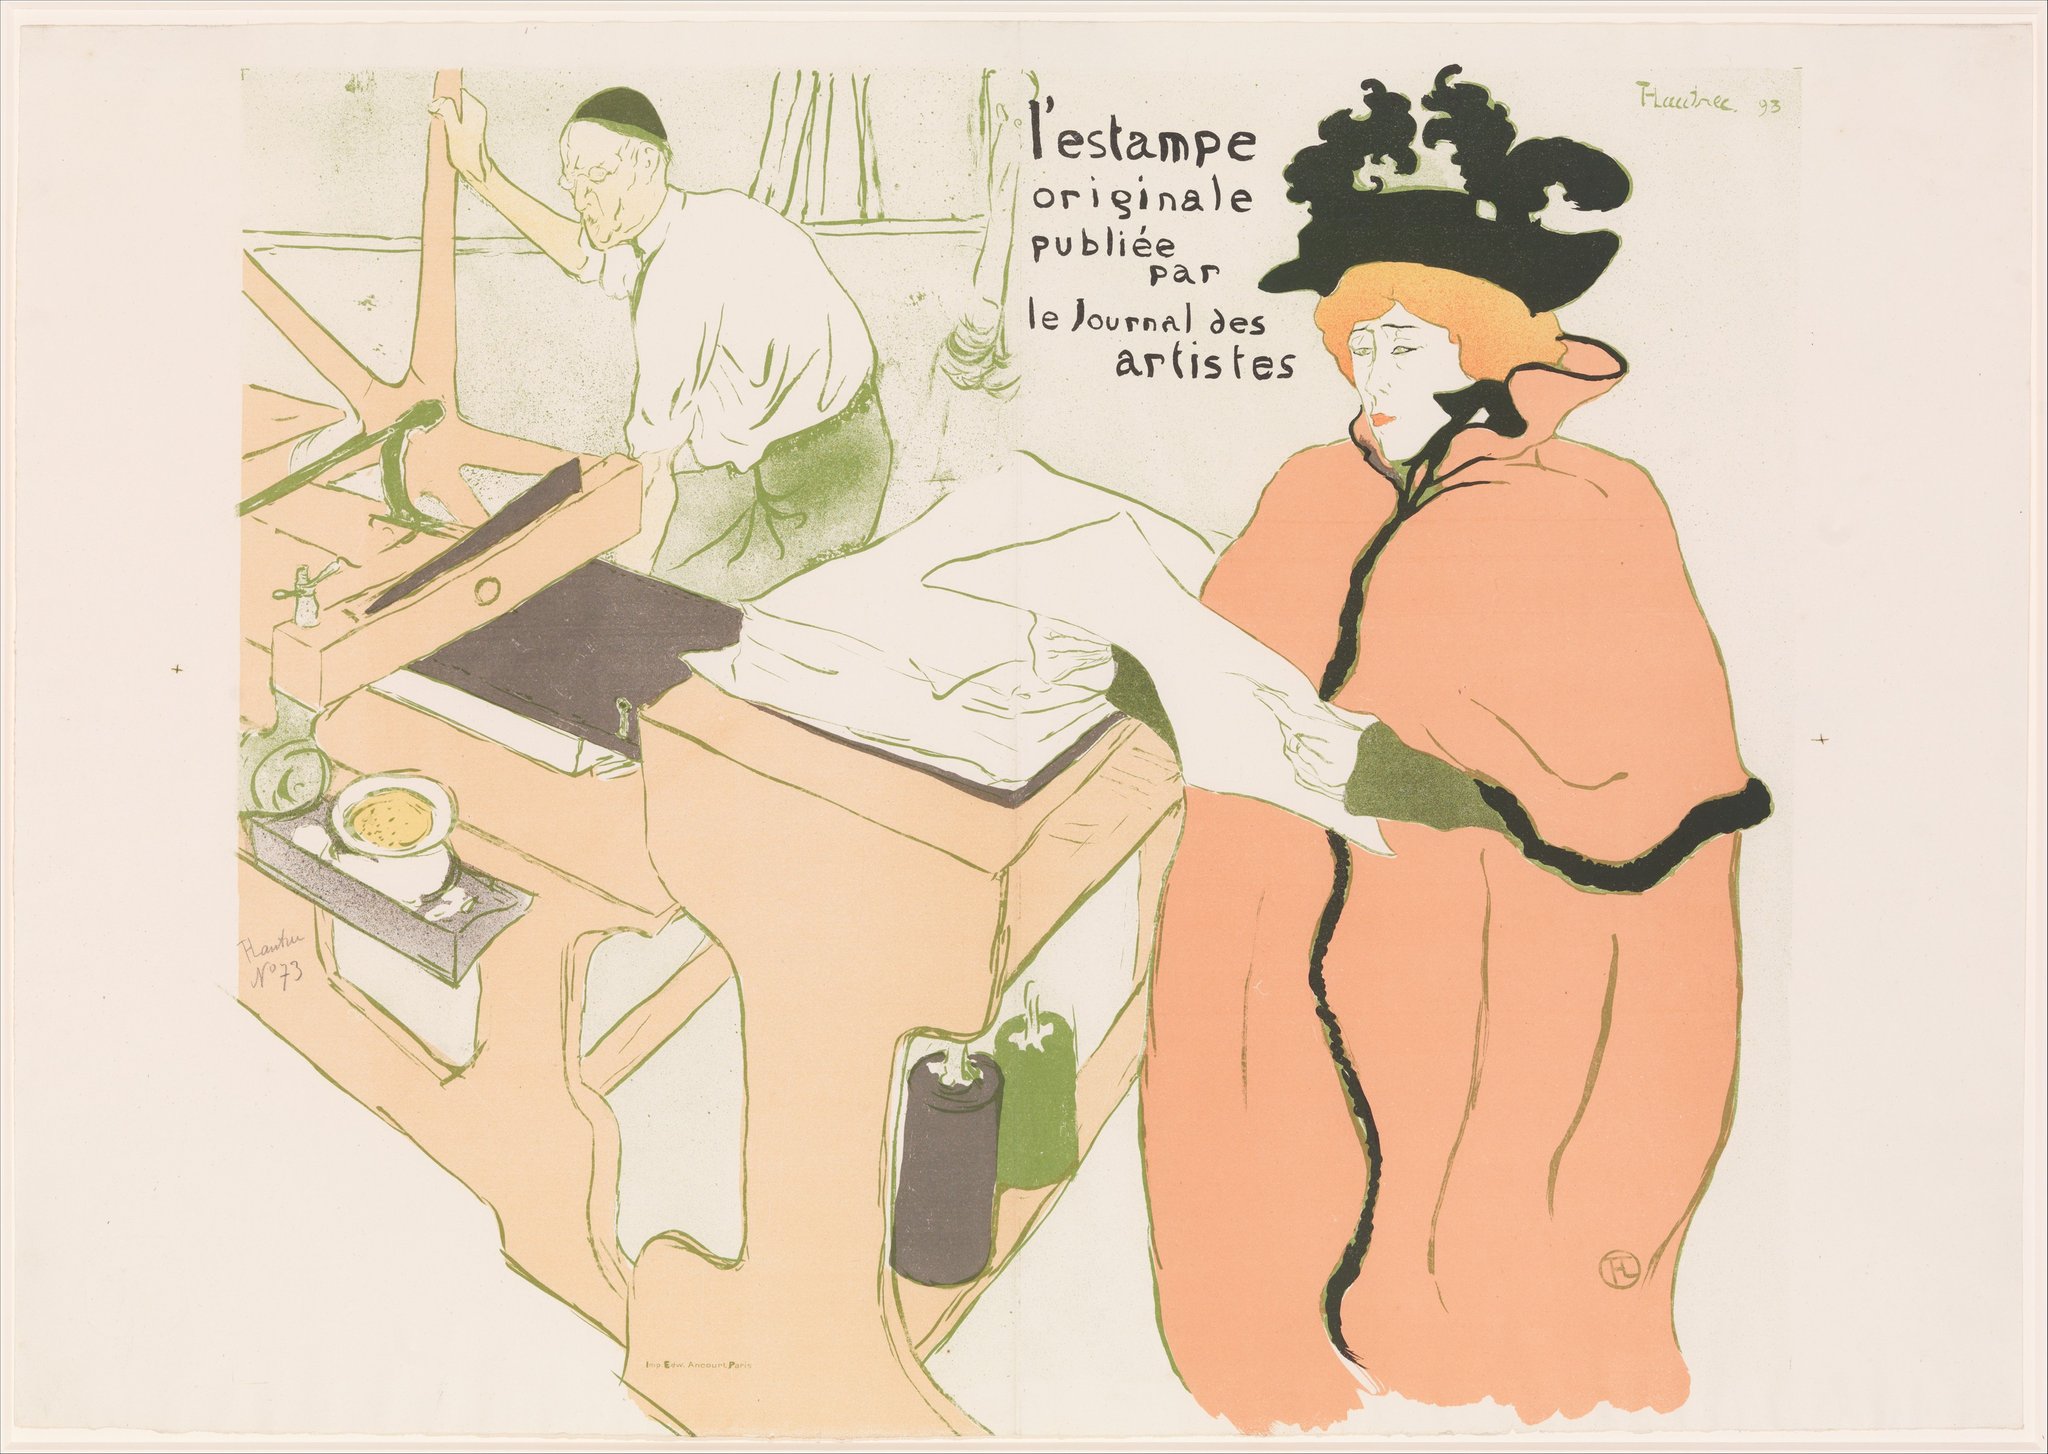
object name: print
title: Cover for "L'Estampe originale, Album I, publiée par les Journal des Artistes"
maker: henri de toulouse-lautrec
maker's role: artist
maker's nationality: french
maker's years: 1864-1901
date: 1893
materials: paper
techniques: lithograph, printing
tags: men,women,reading